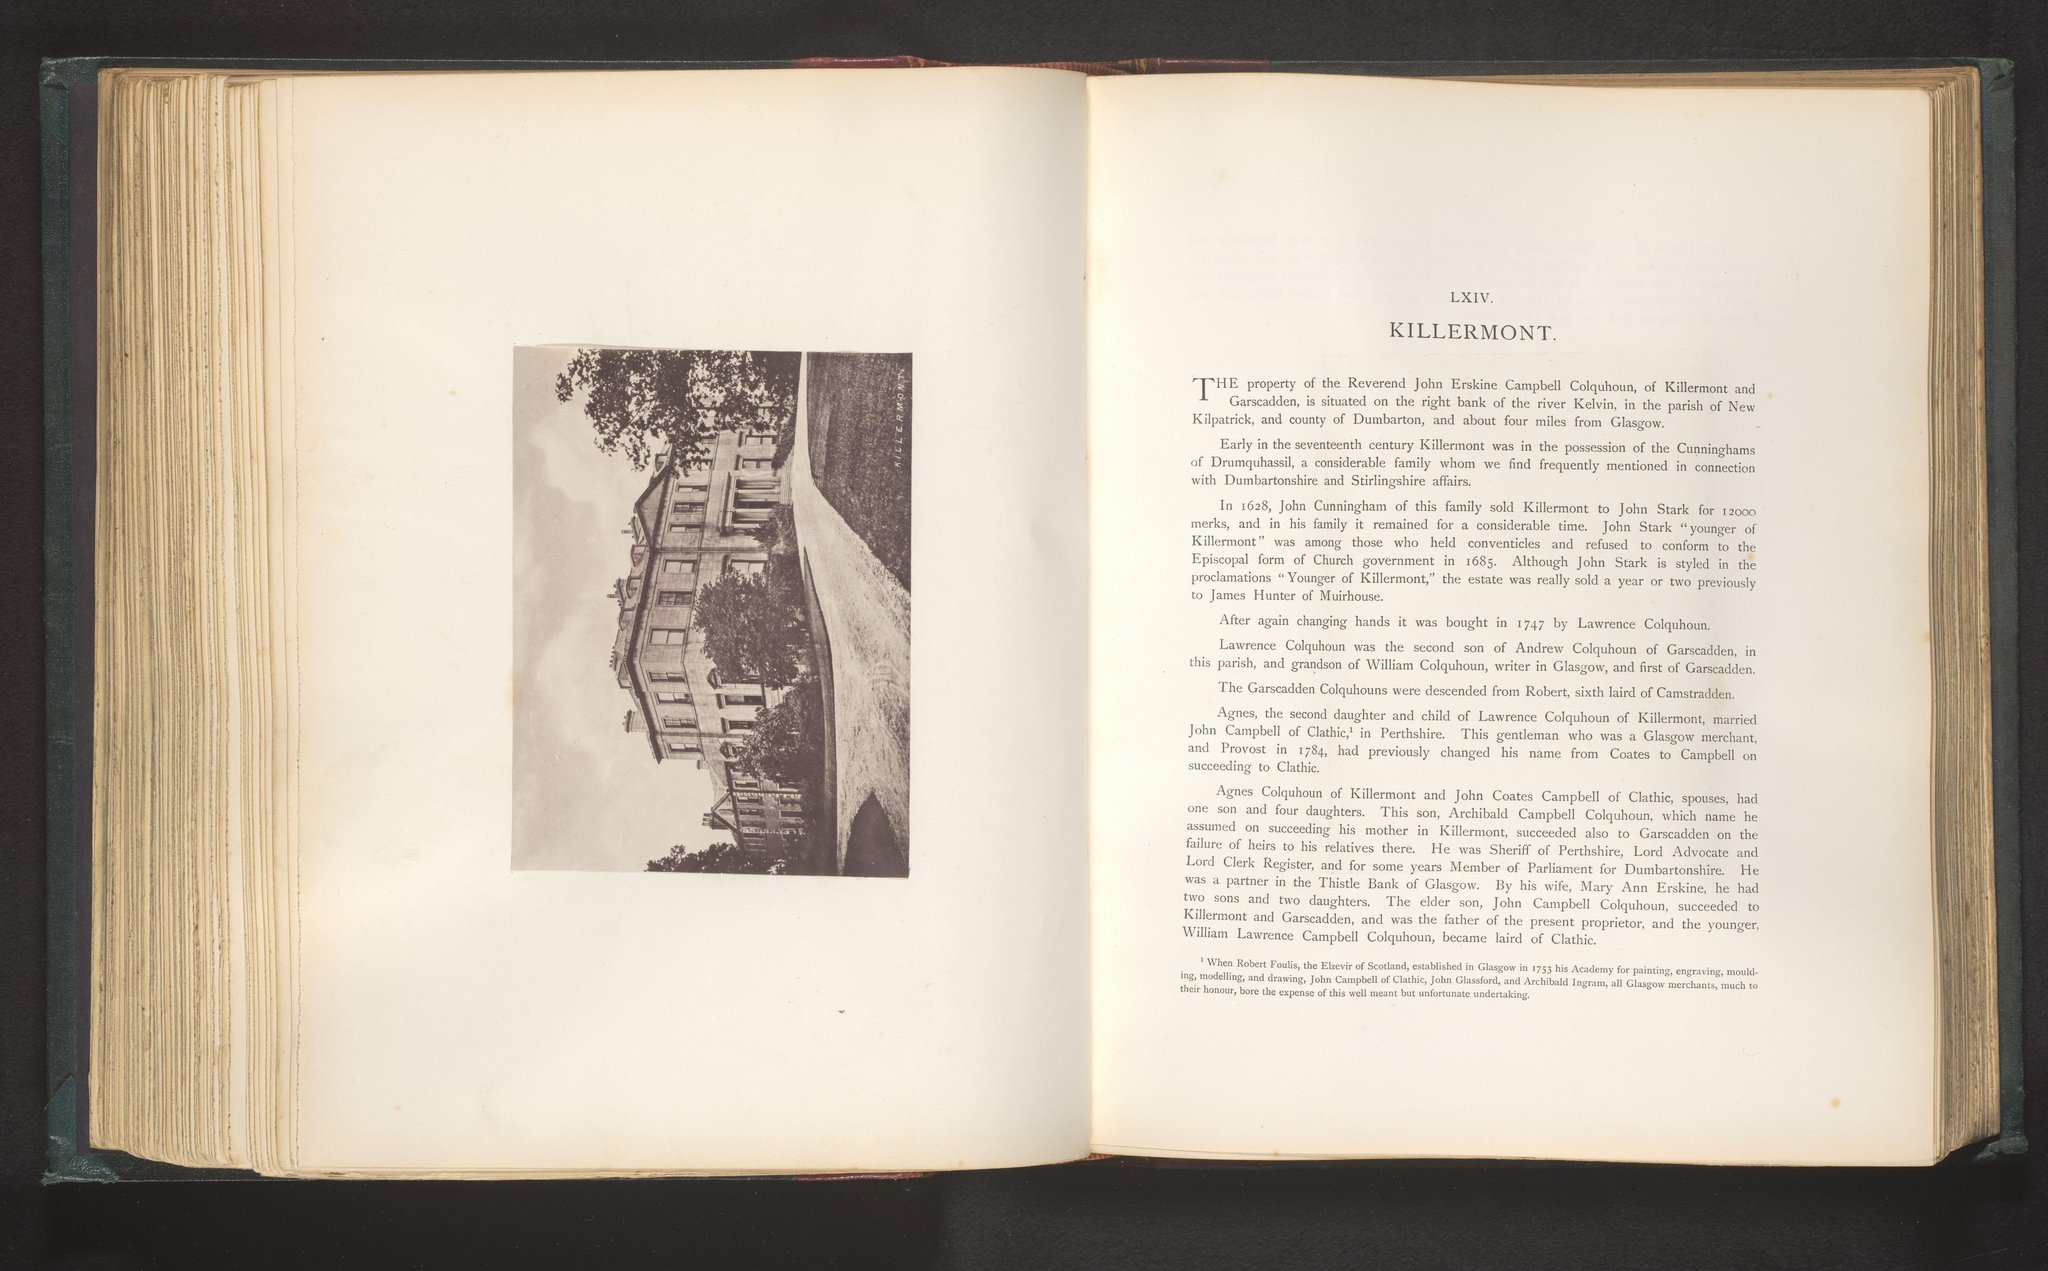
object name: page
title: Killermont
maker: thomas annan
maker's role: fotograaf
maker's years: 1829-1887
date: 1868-1878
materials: paper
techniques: carbon print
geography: bearsden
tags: rural housing, e.g. country-house, villa, cottage, façade (of house or building)